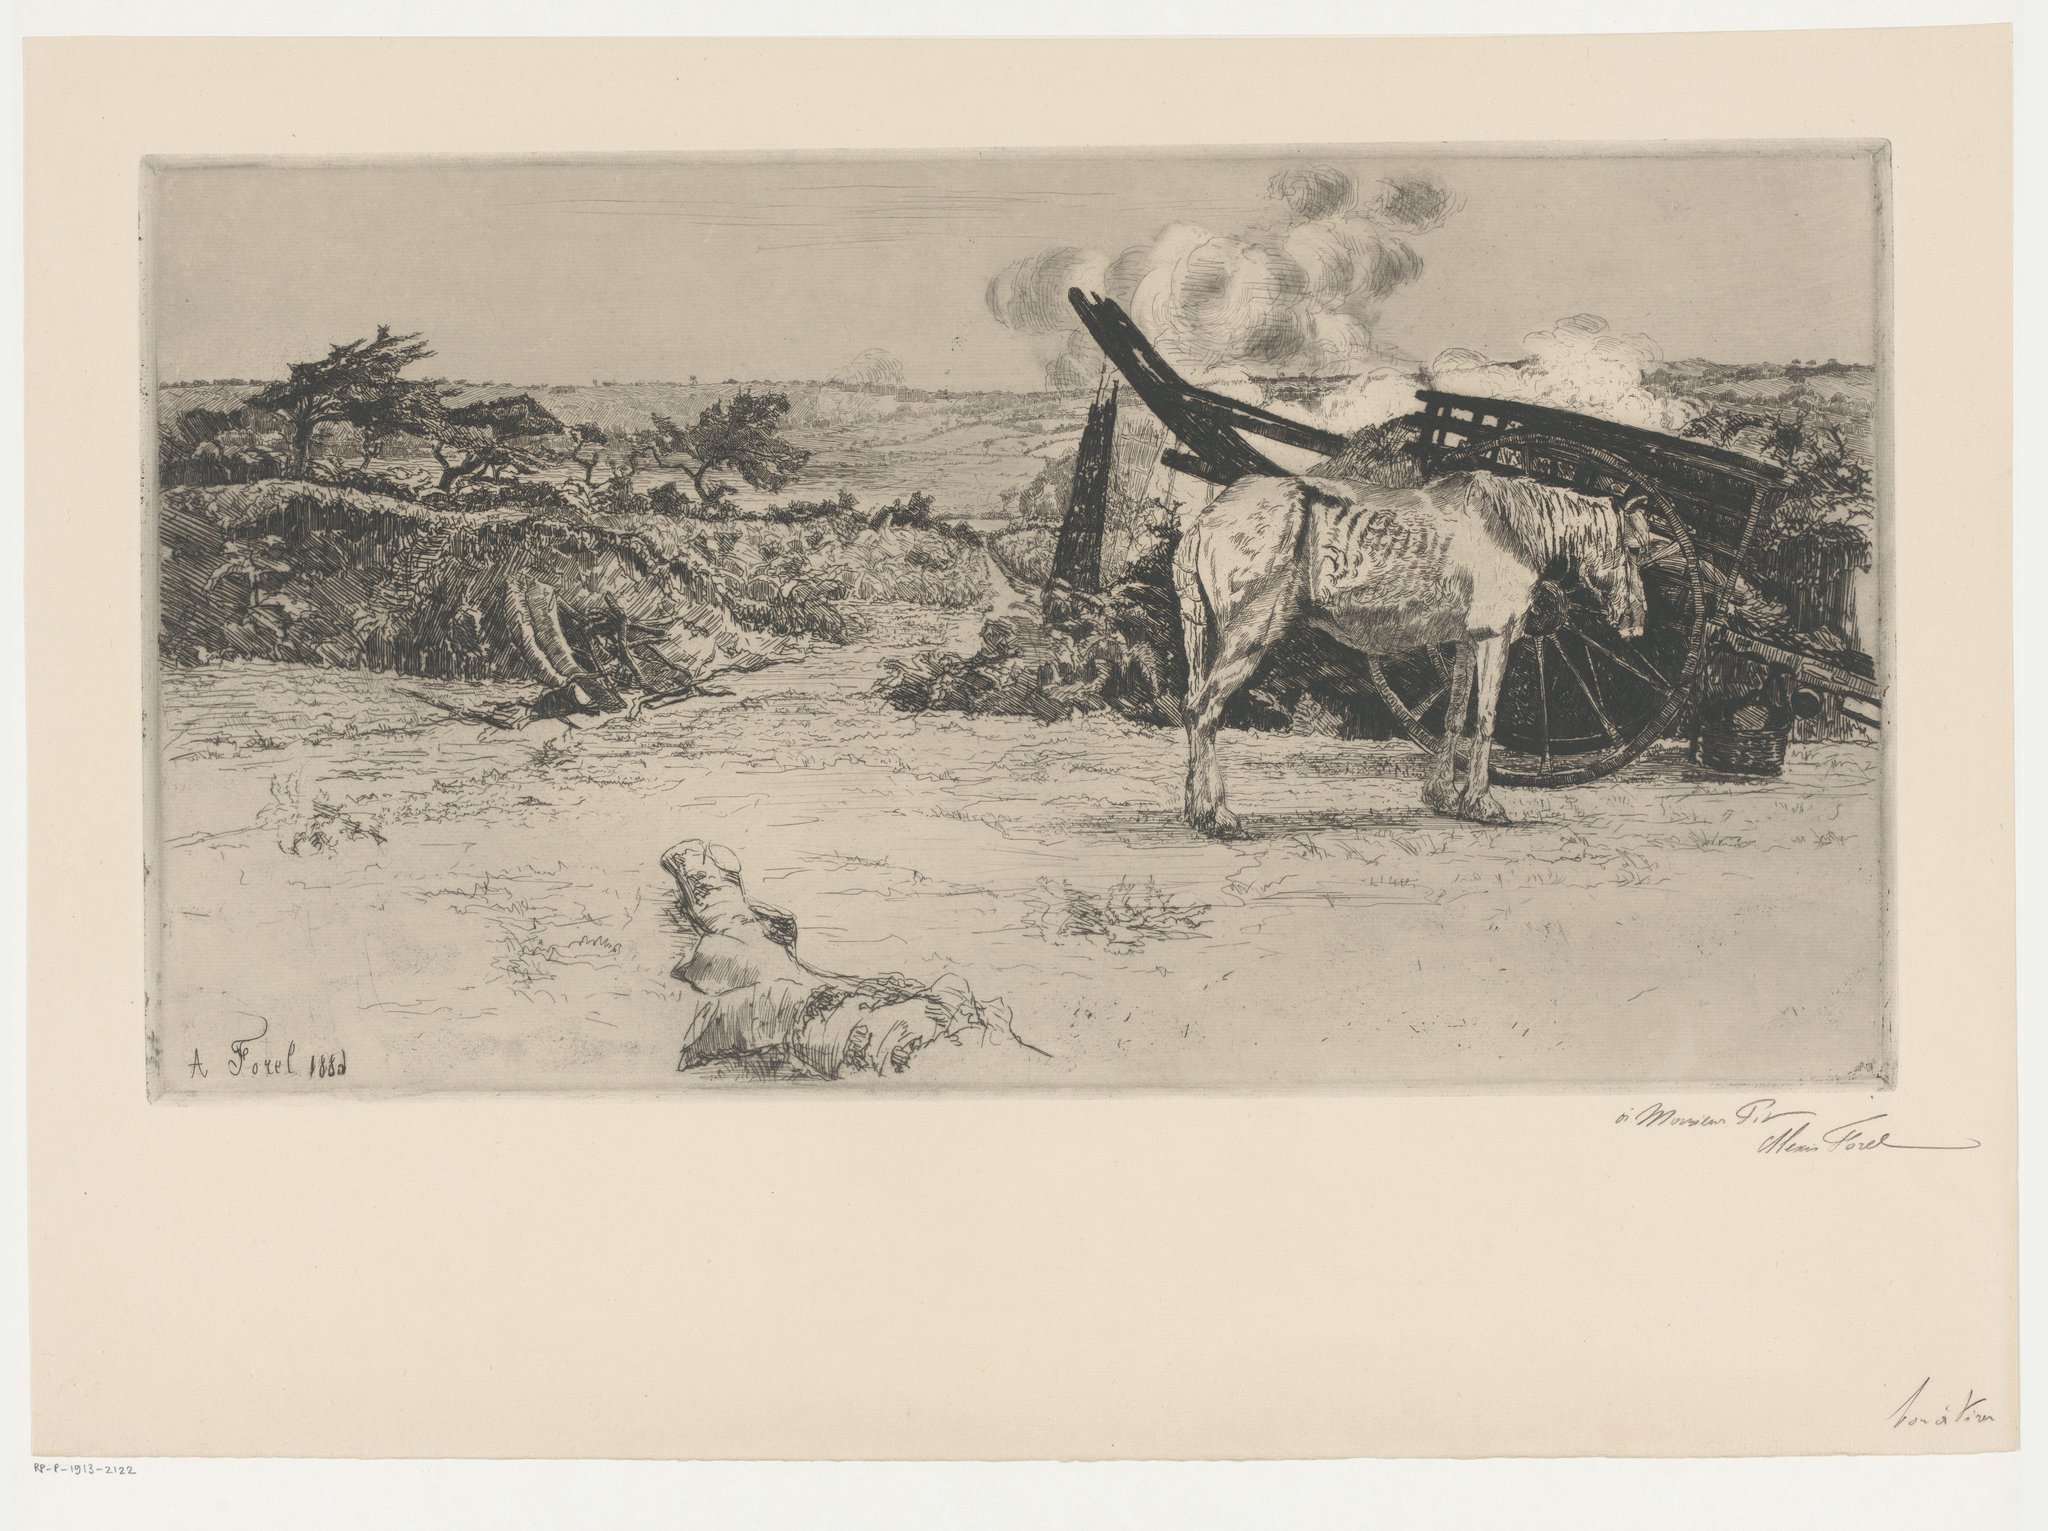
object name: print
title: Landschap met een afgespannen paard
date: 1886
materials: paper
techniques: drypoint, etching, intaglio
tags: horses and kindred animals, landscapes, four-wheeled, animal-drawn vehicle, e.g.: cab, carriage, coach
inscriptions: collector's mark: Lugt 2233